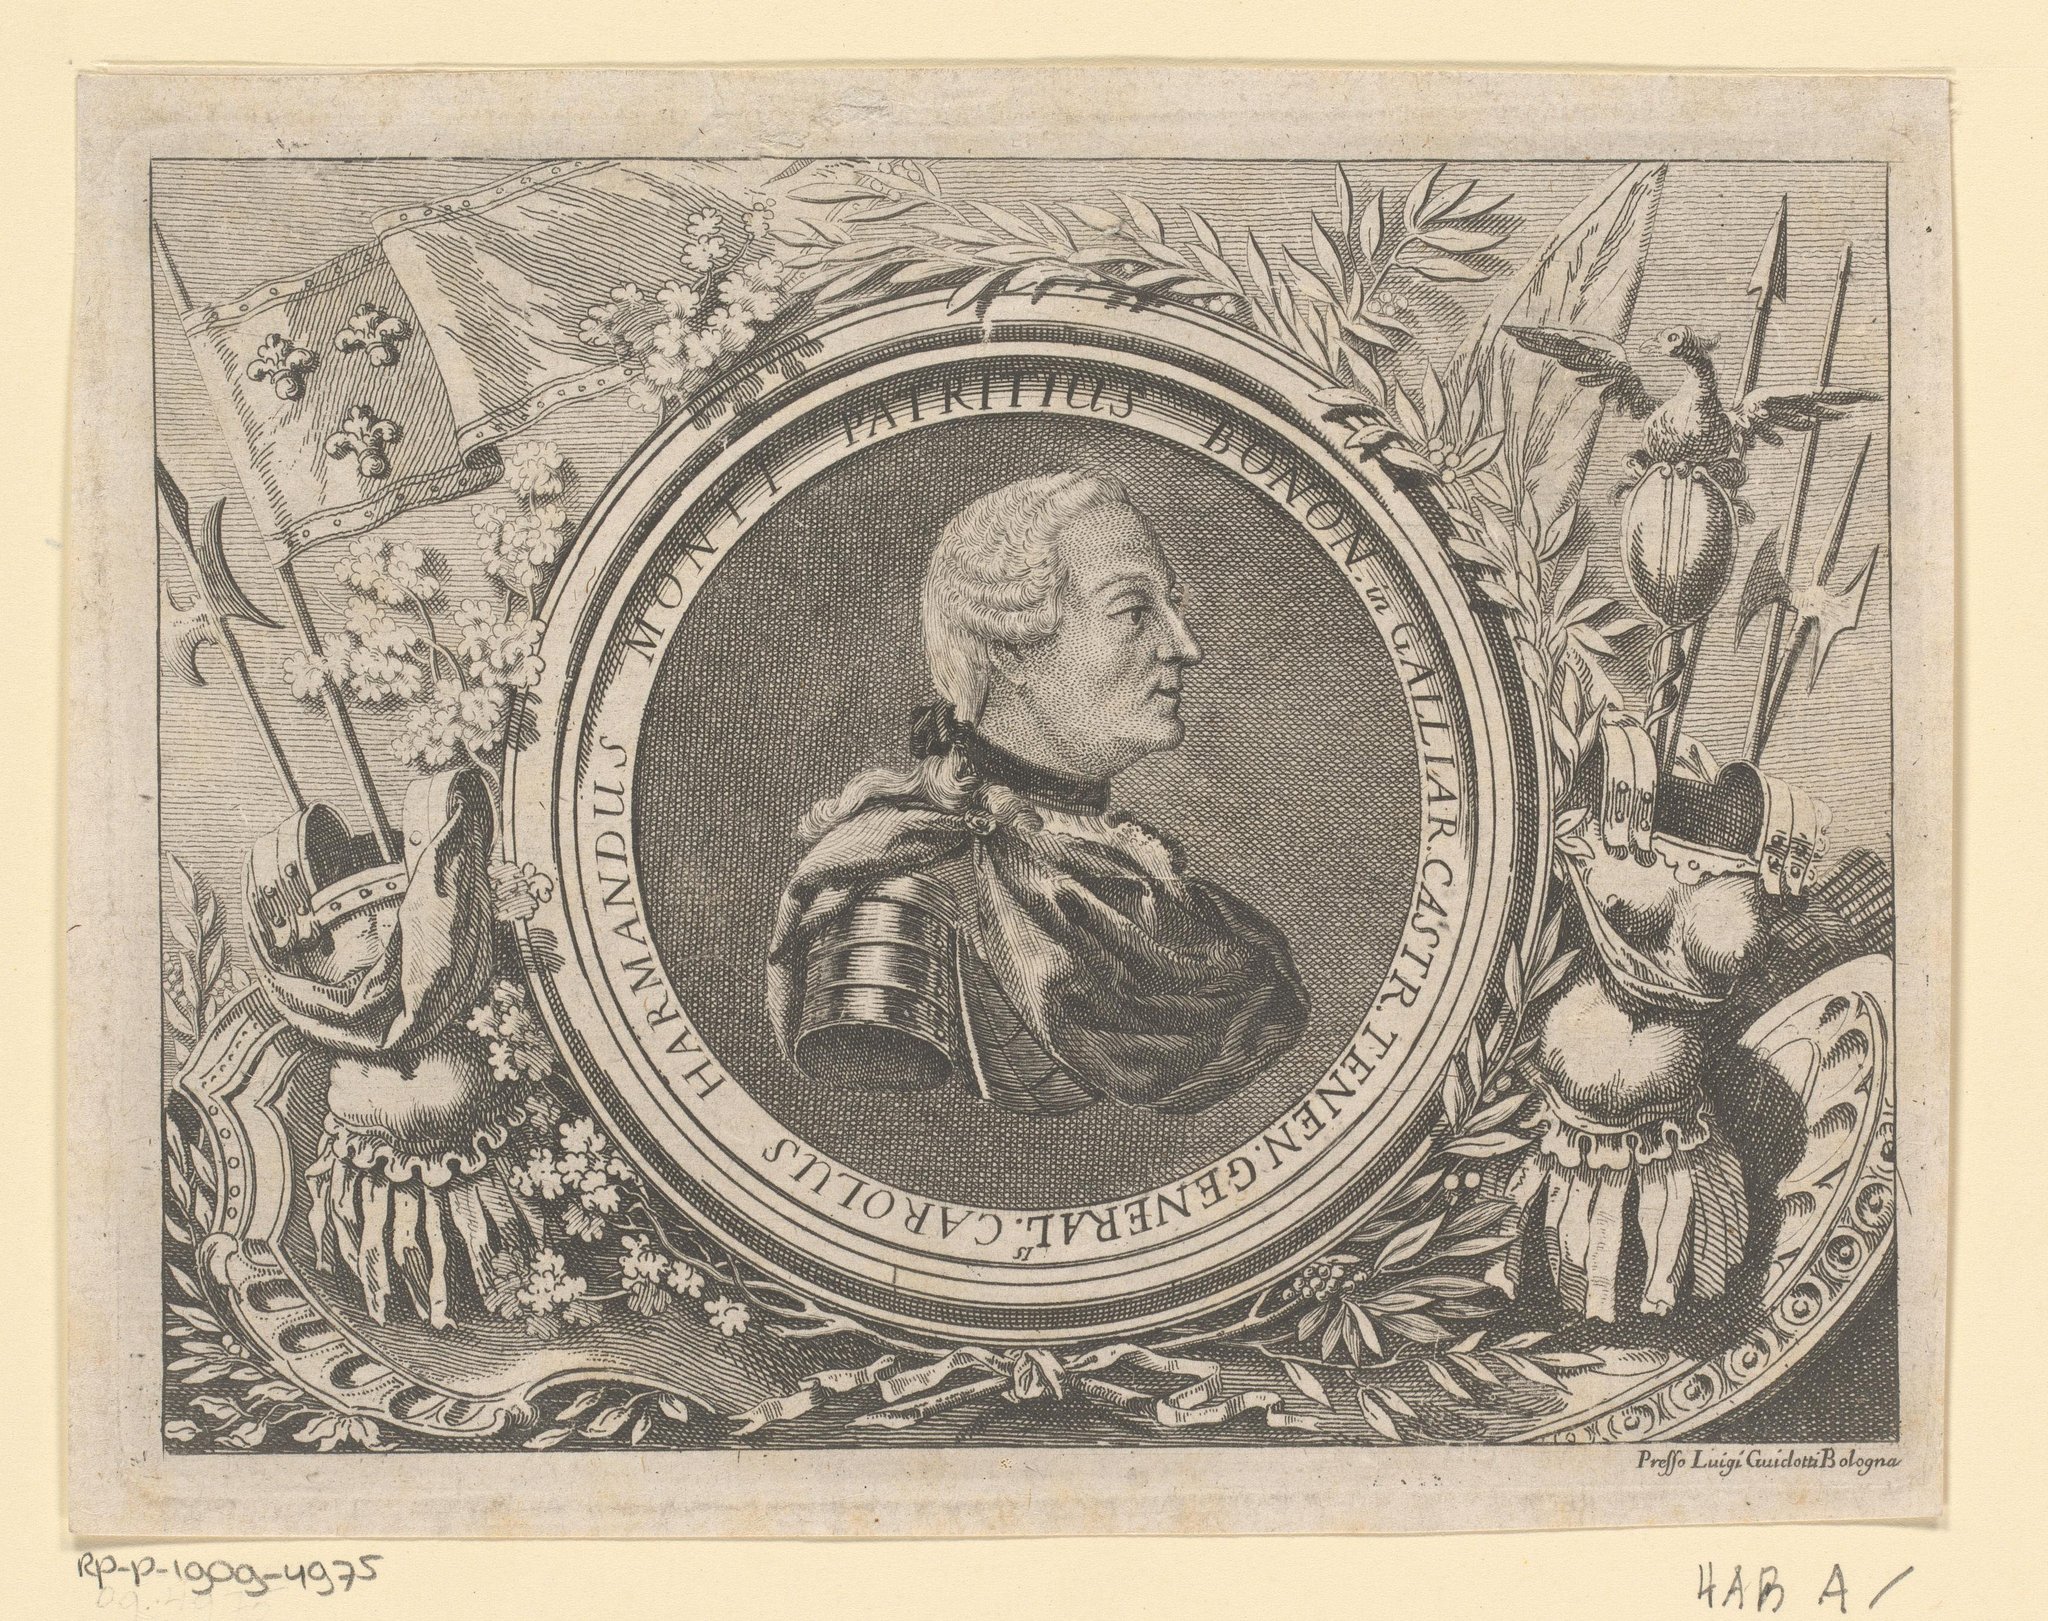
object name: print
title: Portret van Carlo Armando Monti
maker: luigi guidotti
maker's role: print maker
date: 1700-1800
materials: paper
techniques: engraving, etching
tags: commander-in-chief, general, marshal, historical persons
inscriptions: collector's mark: Lugt 2228